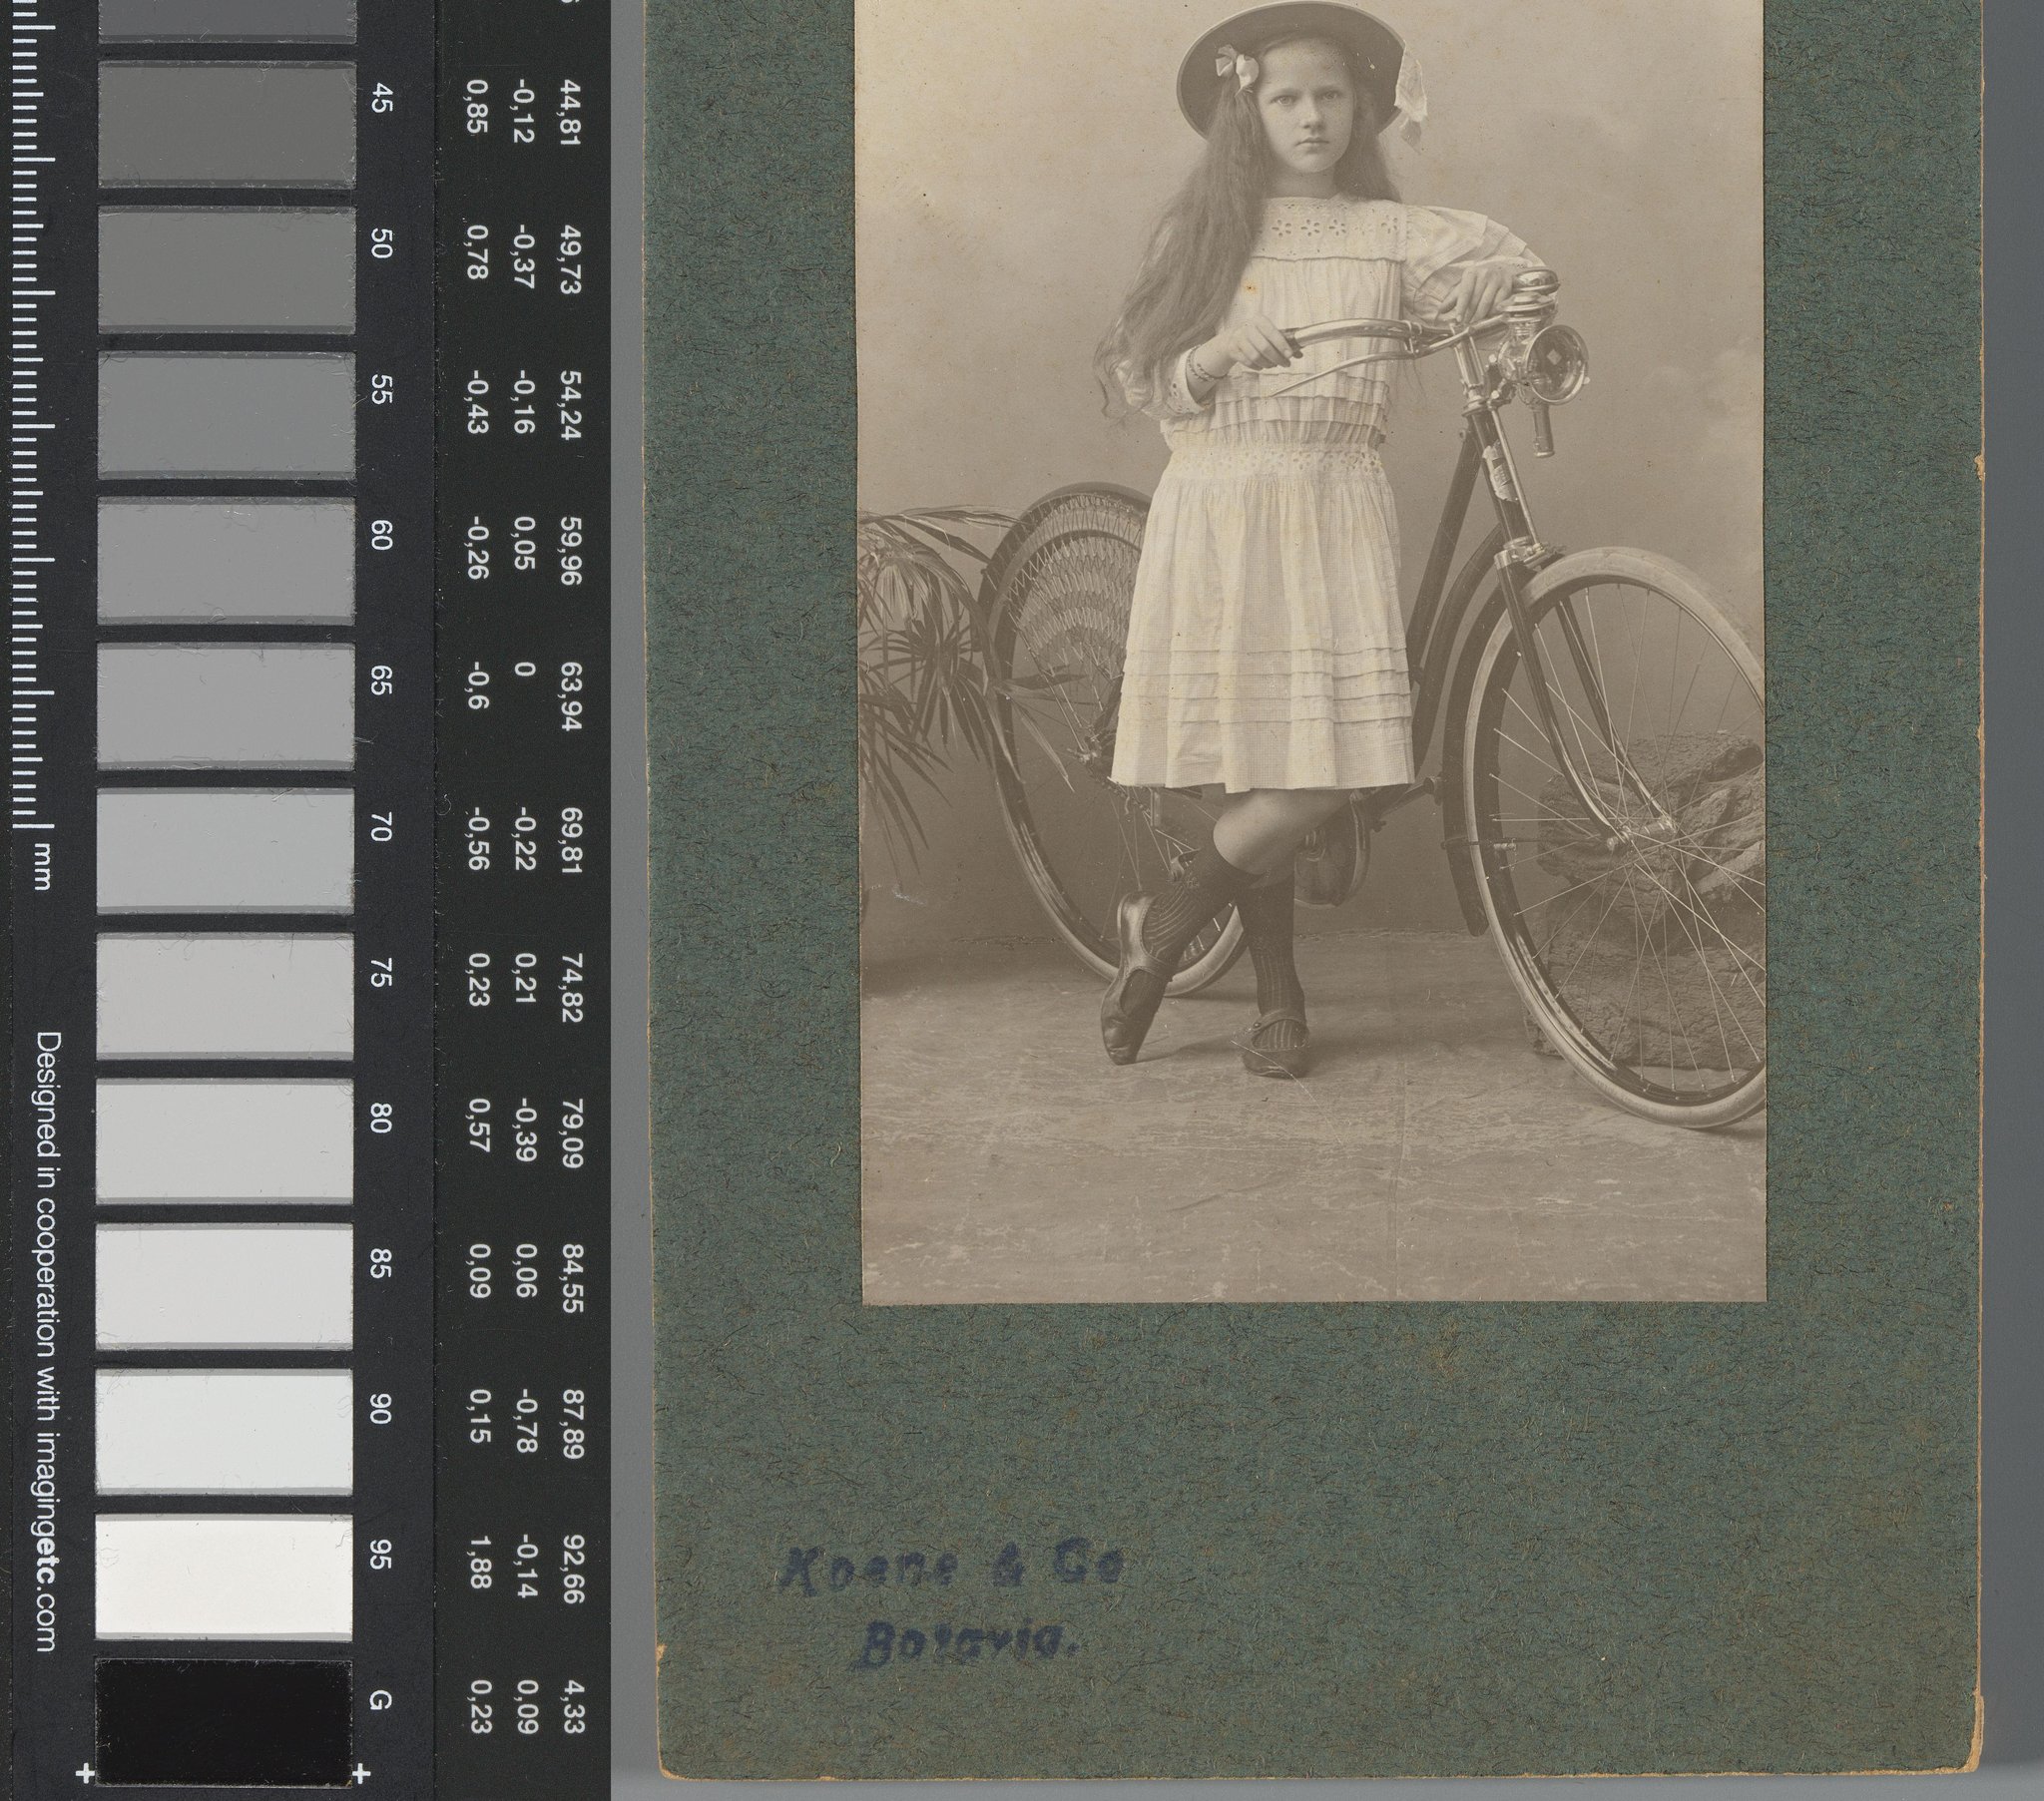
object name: photograph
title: Portret van van een dochter van Piet Onnen en Emilie van den Berg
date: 1900-1915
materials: photographic support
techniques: albumen print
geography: batavia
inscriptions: name: ‘Koene & Co / Batavia.’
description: Studioportret van een meisje met hoed en fiets.